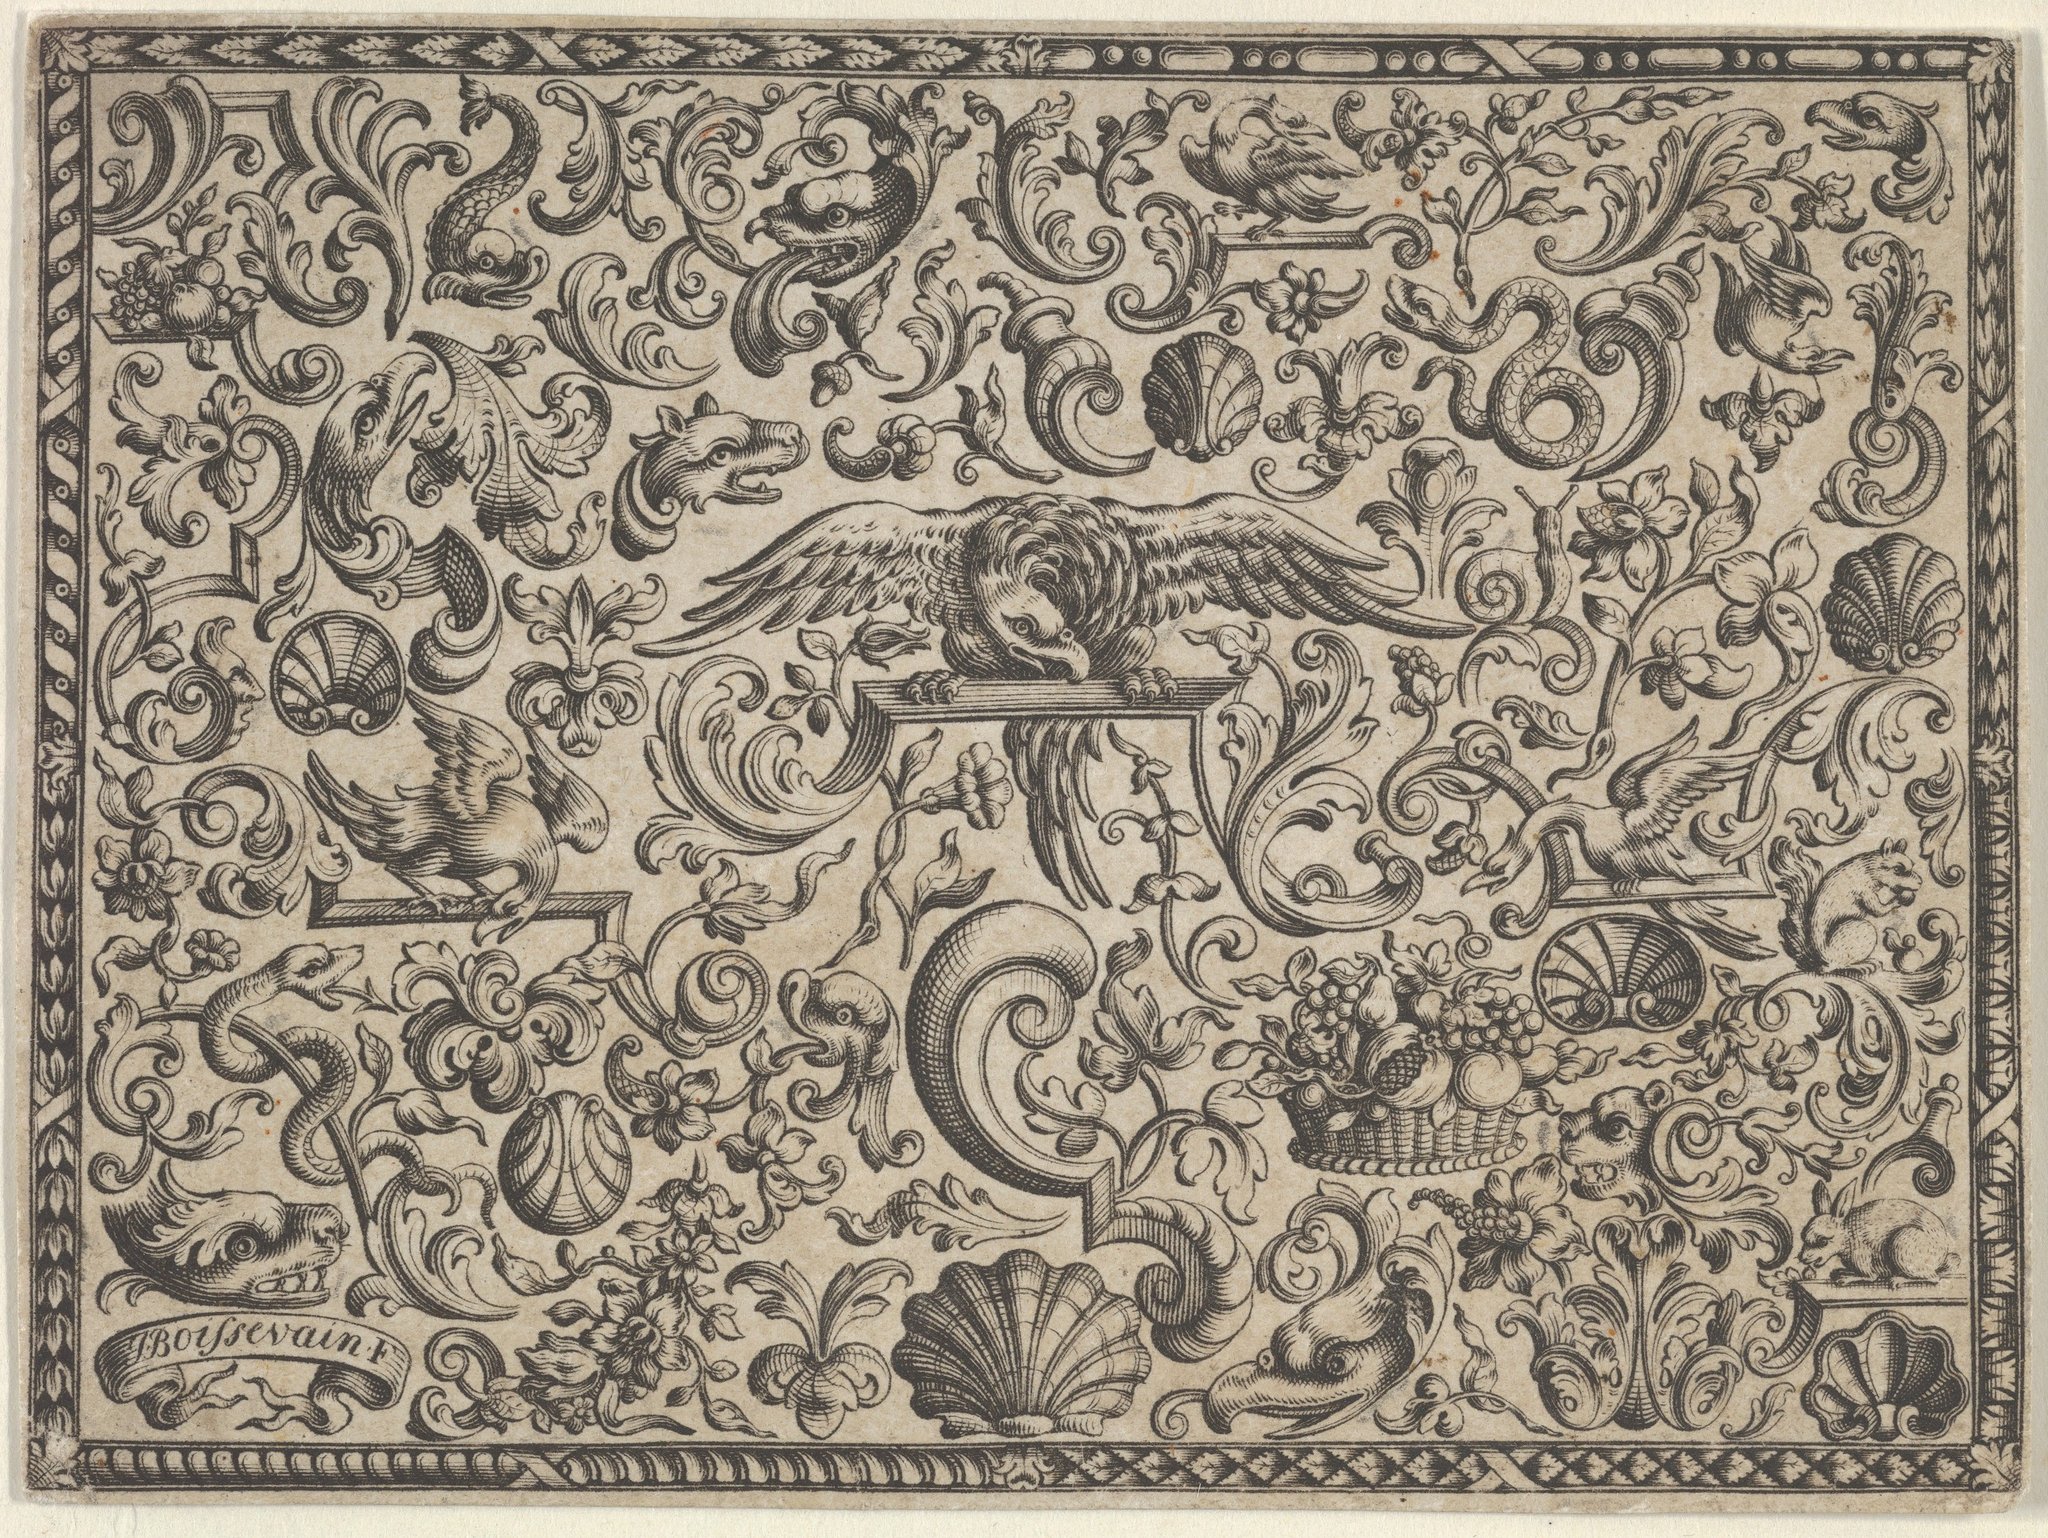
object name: print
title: Horizontal Panel with a Bird Perched at Center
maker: j. boissevain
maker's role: artist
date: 1501-1700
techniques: engraving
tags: birds,snakes